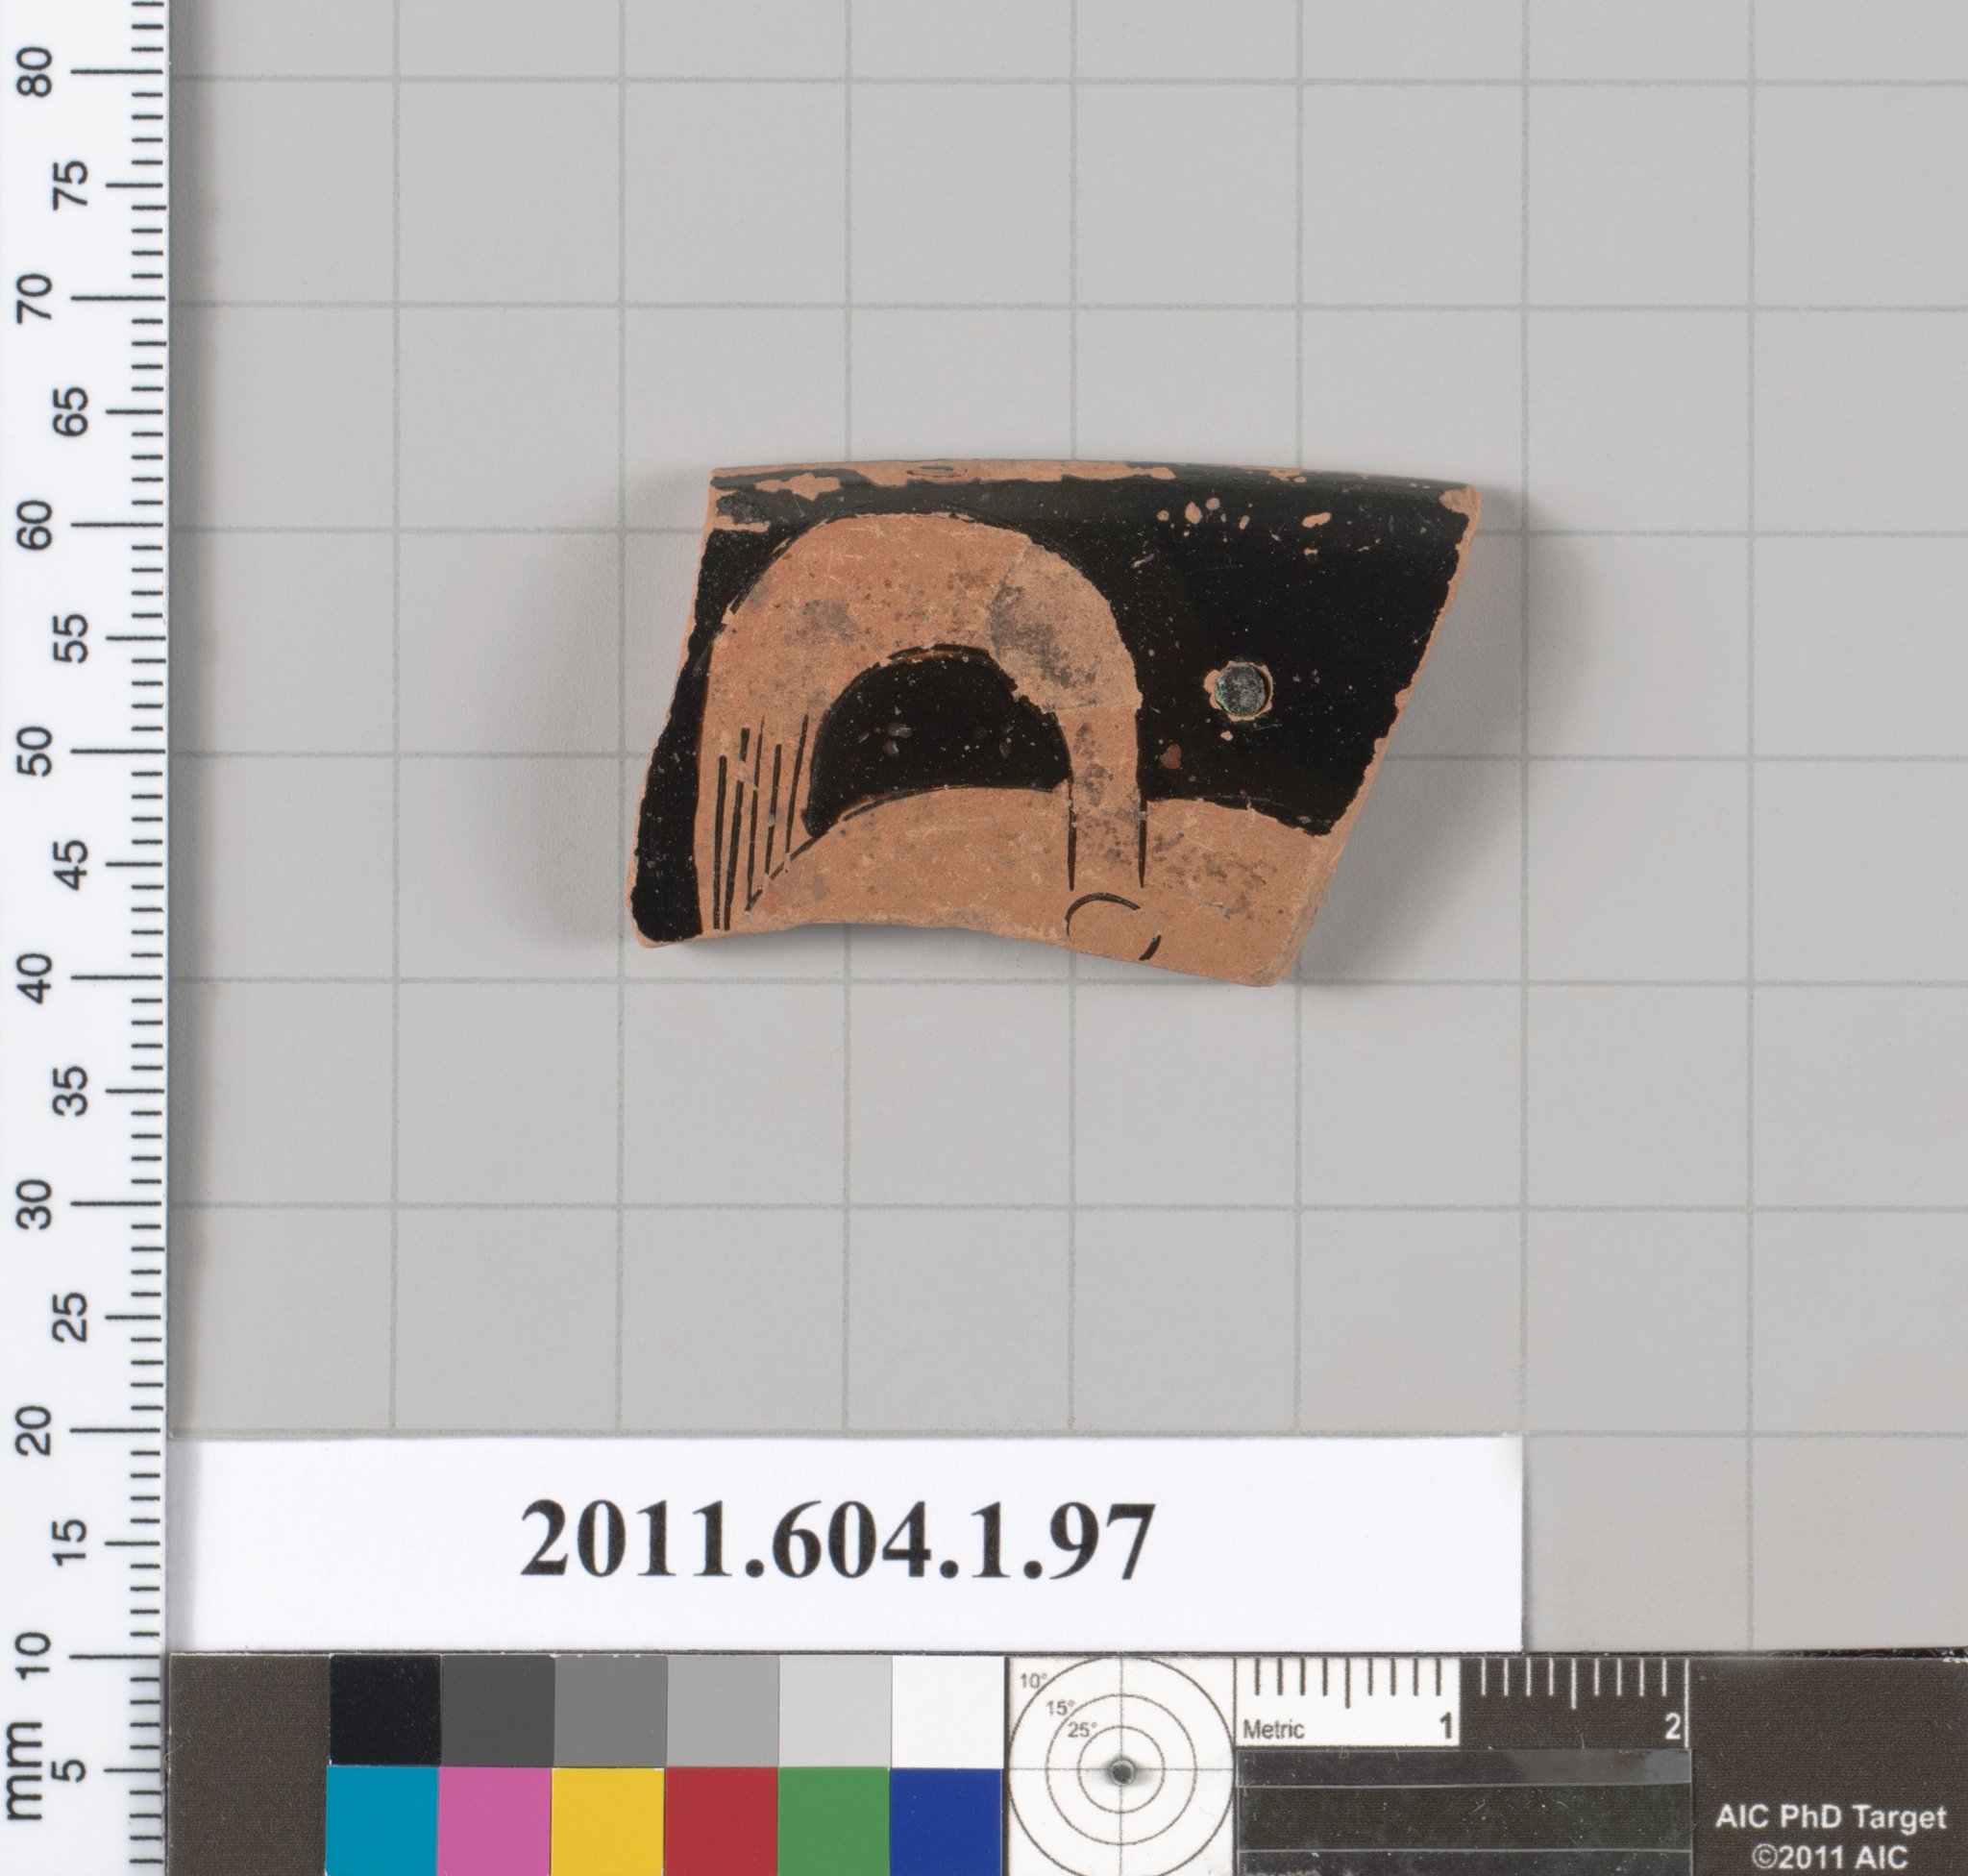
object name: kylix fragment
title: Terracotta rim fragment of a kylix (drinking cup)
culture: greek, attic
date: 475-451 BCE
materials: terracotta